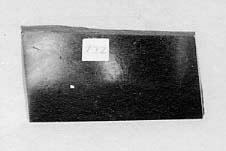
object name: fragment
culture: russian, siberia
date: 1902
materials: jade